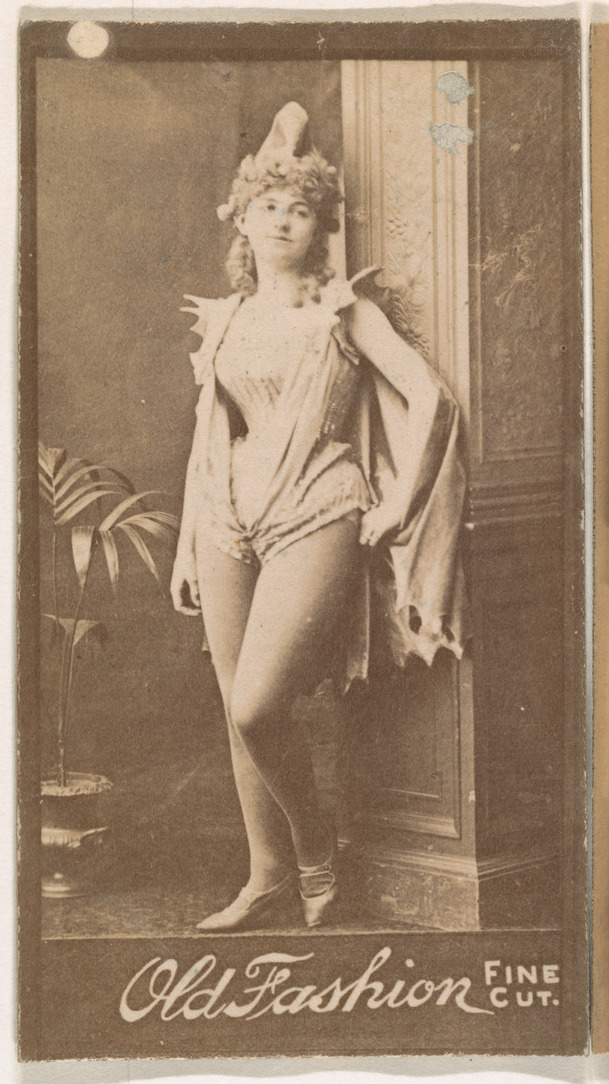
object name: photograph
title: Actress leaning against column, from the Actresses series (N664) promoting Old Fashion Fine Cut Tobacco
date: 1888-1890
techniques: albumen silver print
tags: portraits,women,actresses